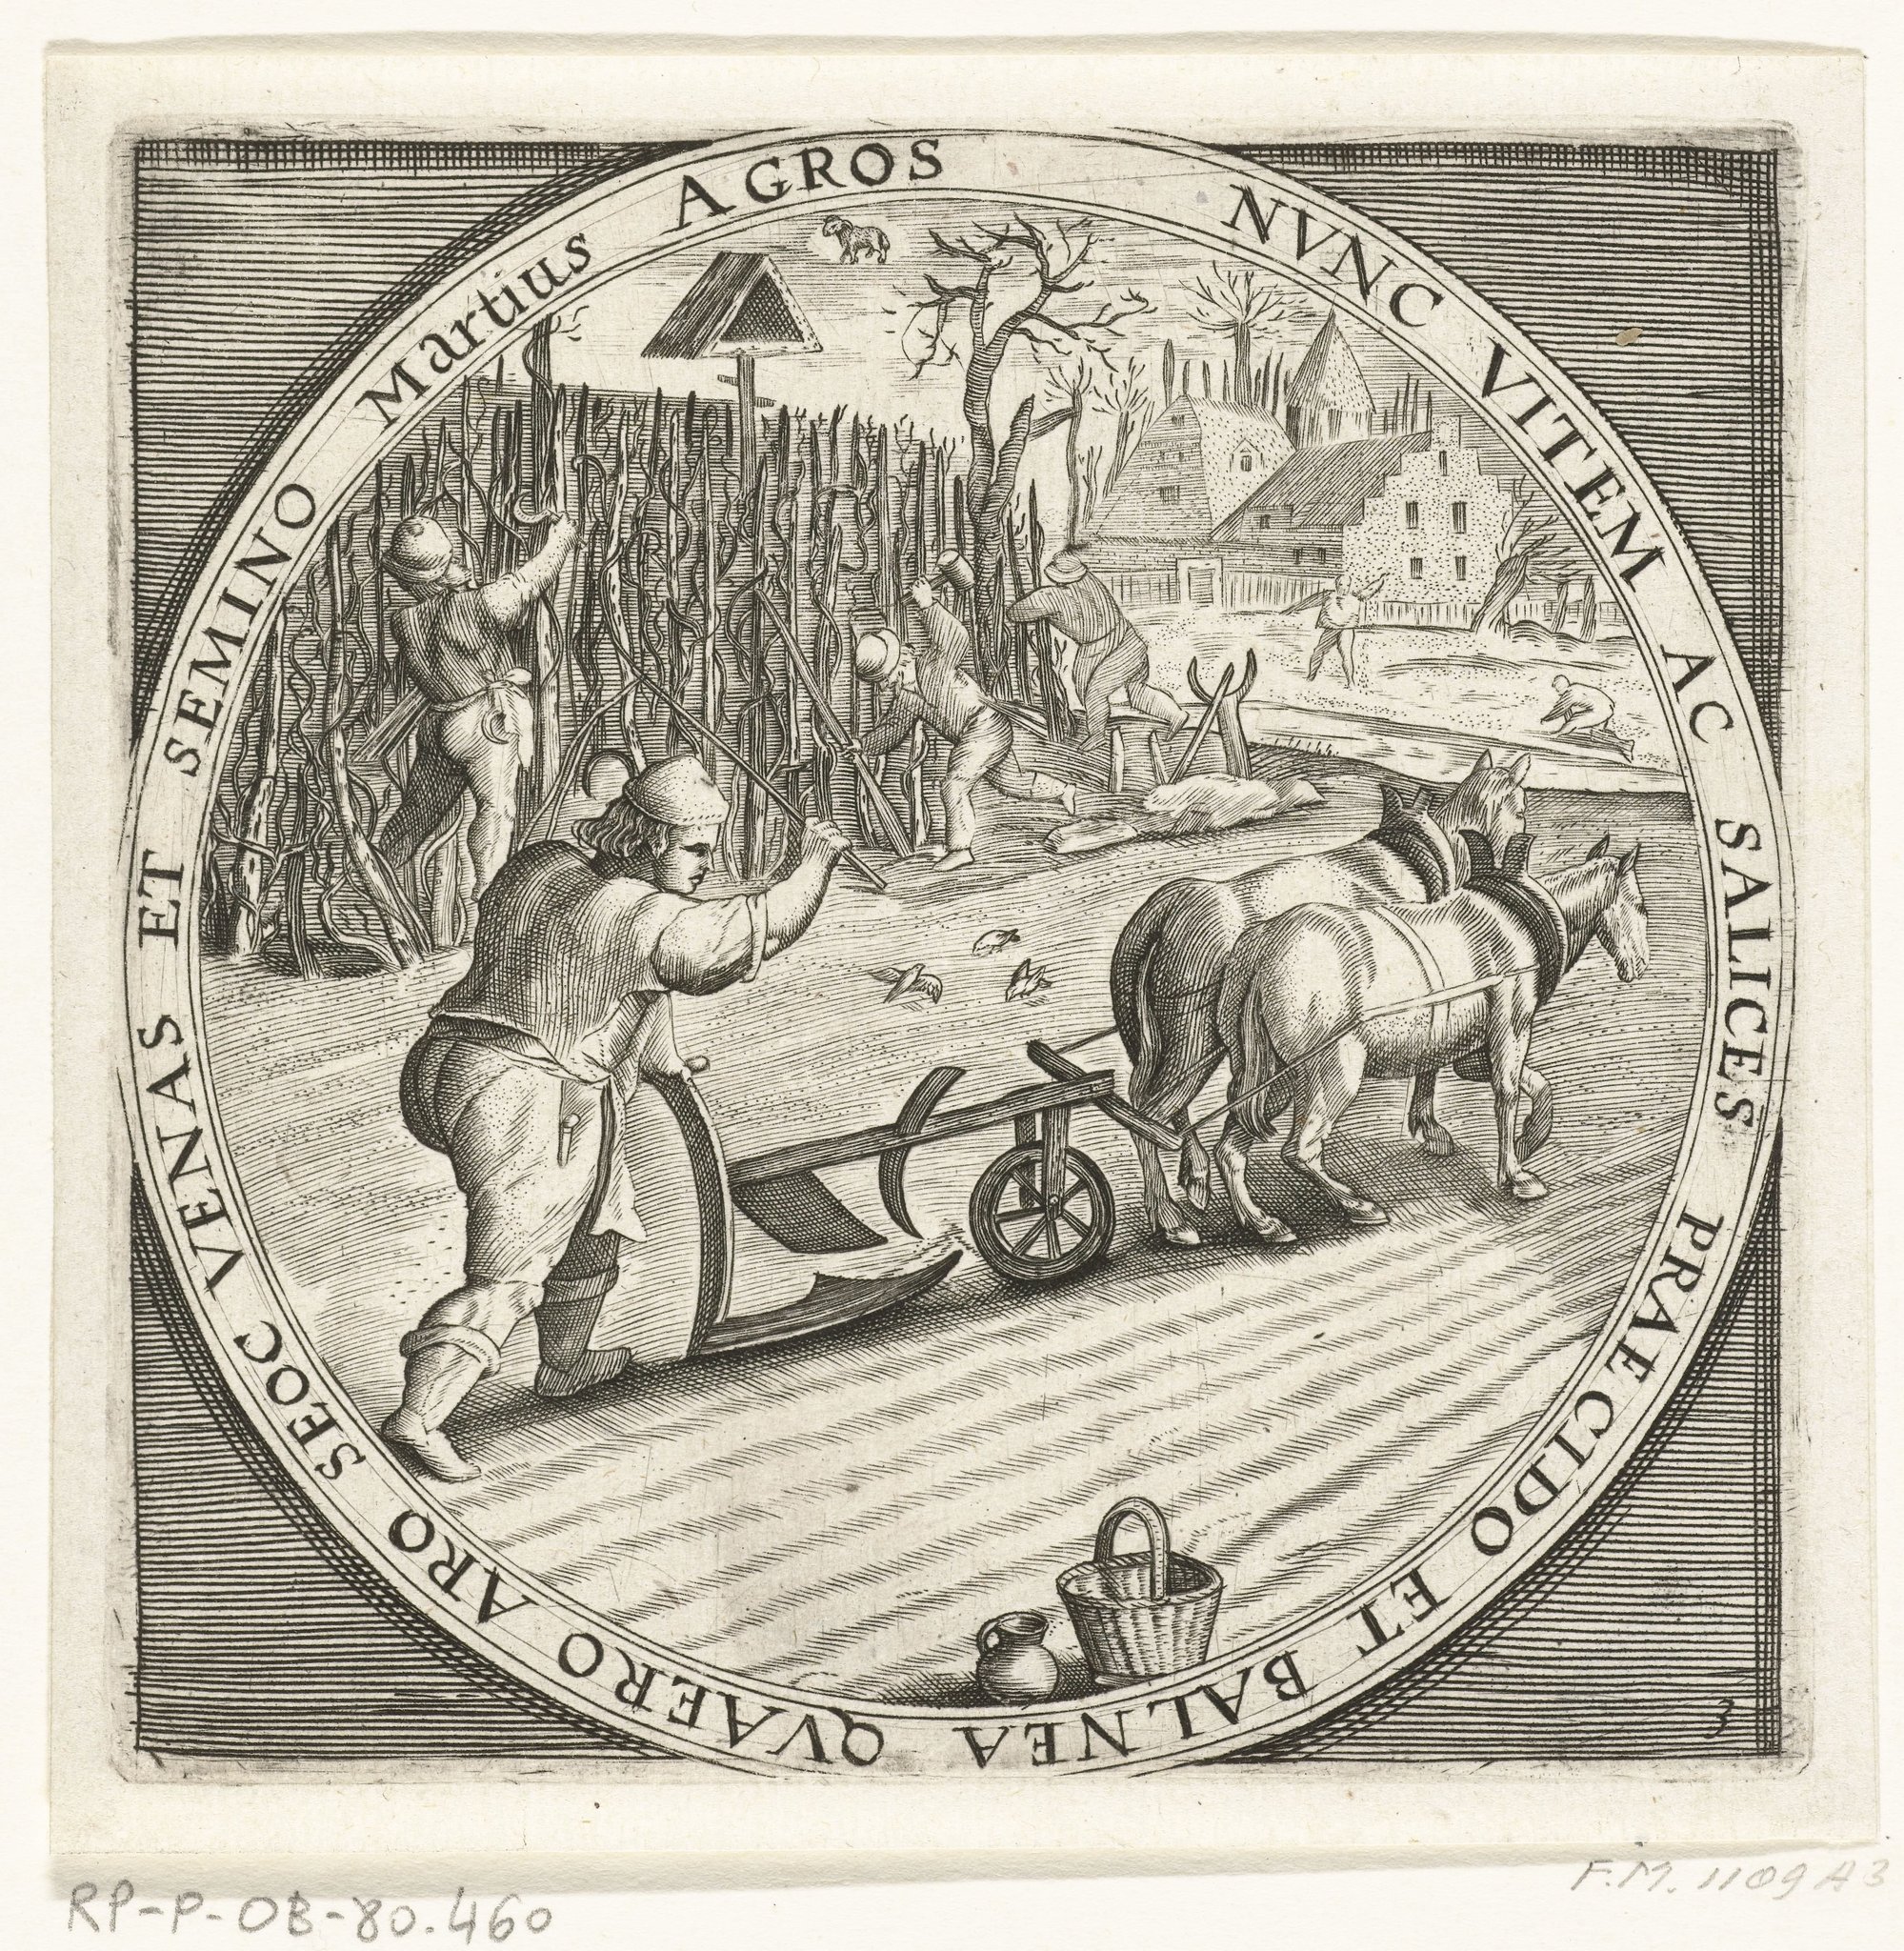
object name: print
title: De twaalf maanden van het jaar verbeeld in scènes uit het volksleven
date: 1600-1649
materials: paper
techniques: engraving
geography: low countries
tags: march and its 'labours', aries (zodical sign of march), ploughing, low countries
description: Ronde voorstelling met de maand maart. Een ploegende boer en werken aan de wijnranken, ca. 1600. Met het teken van de Ram. Met randschrift in het Latijn. Prent nr. 3 in de serie van de twaalf maanden van het jaar verbeeld in scènes uit het volksleven.